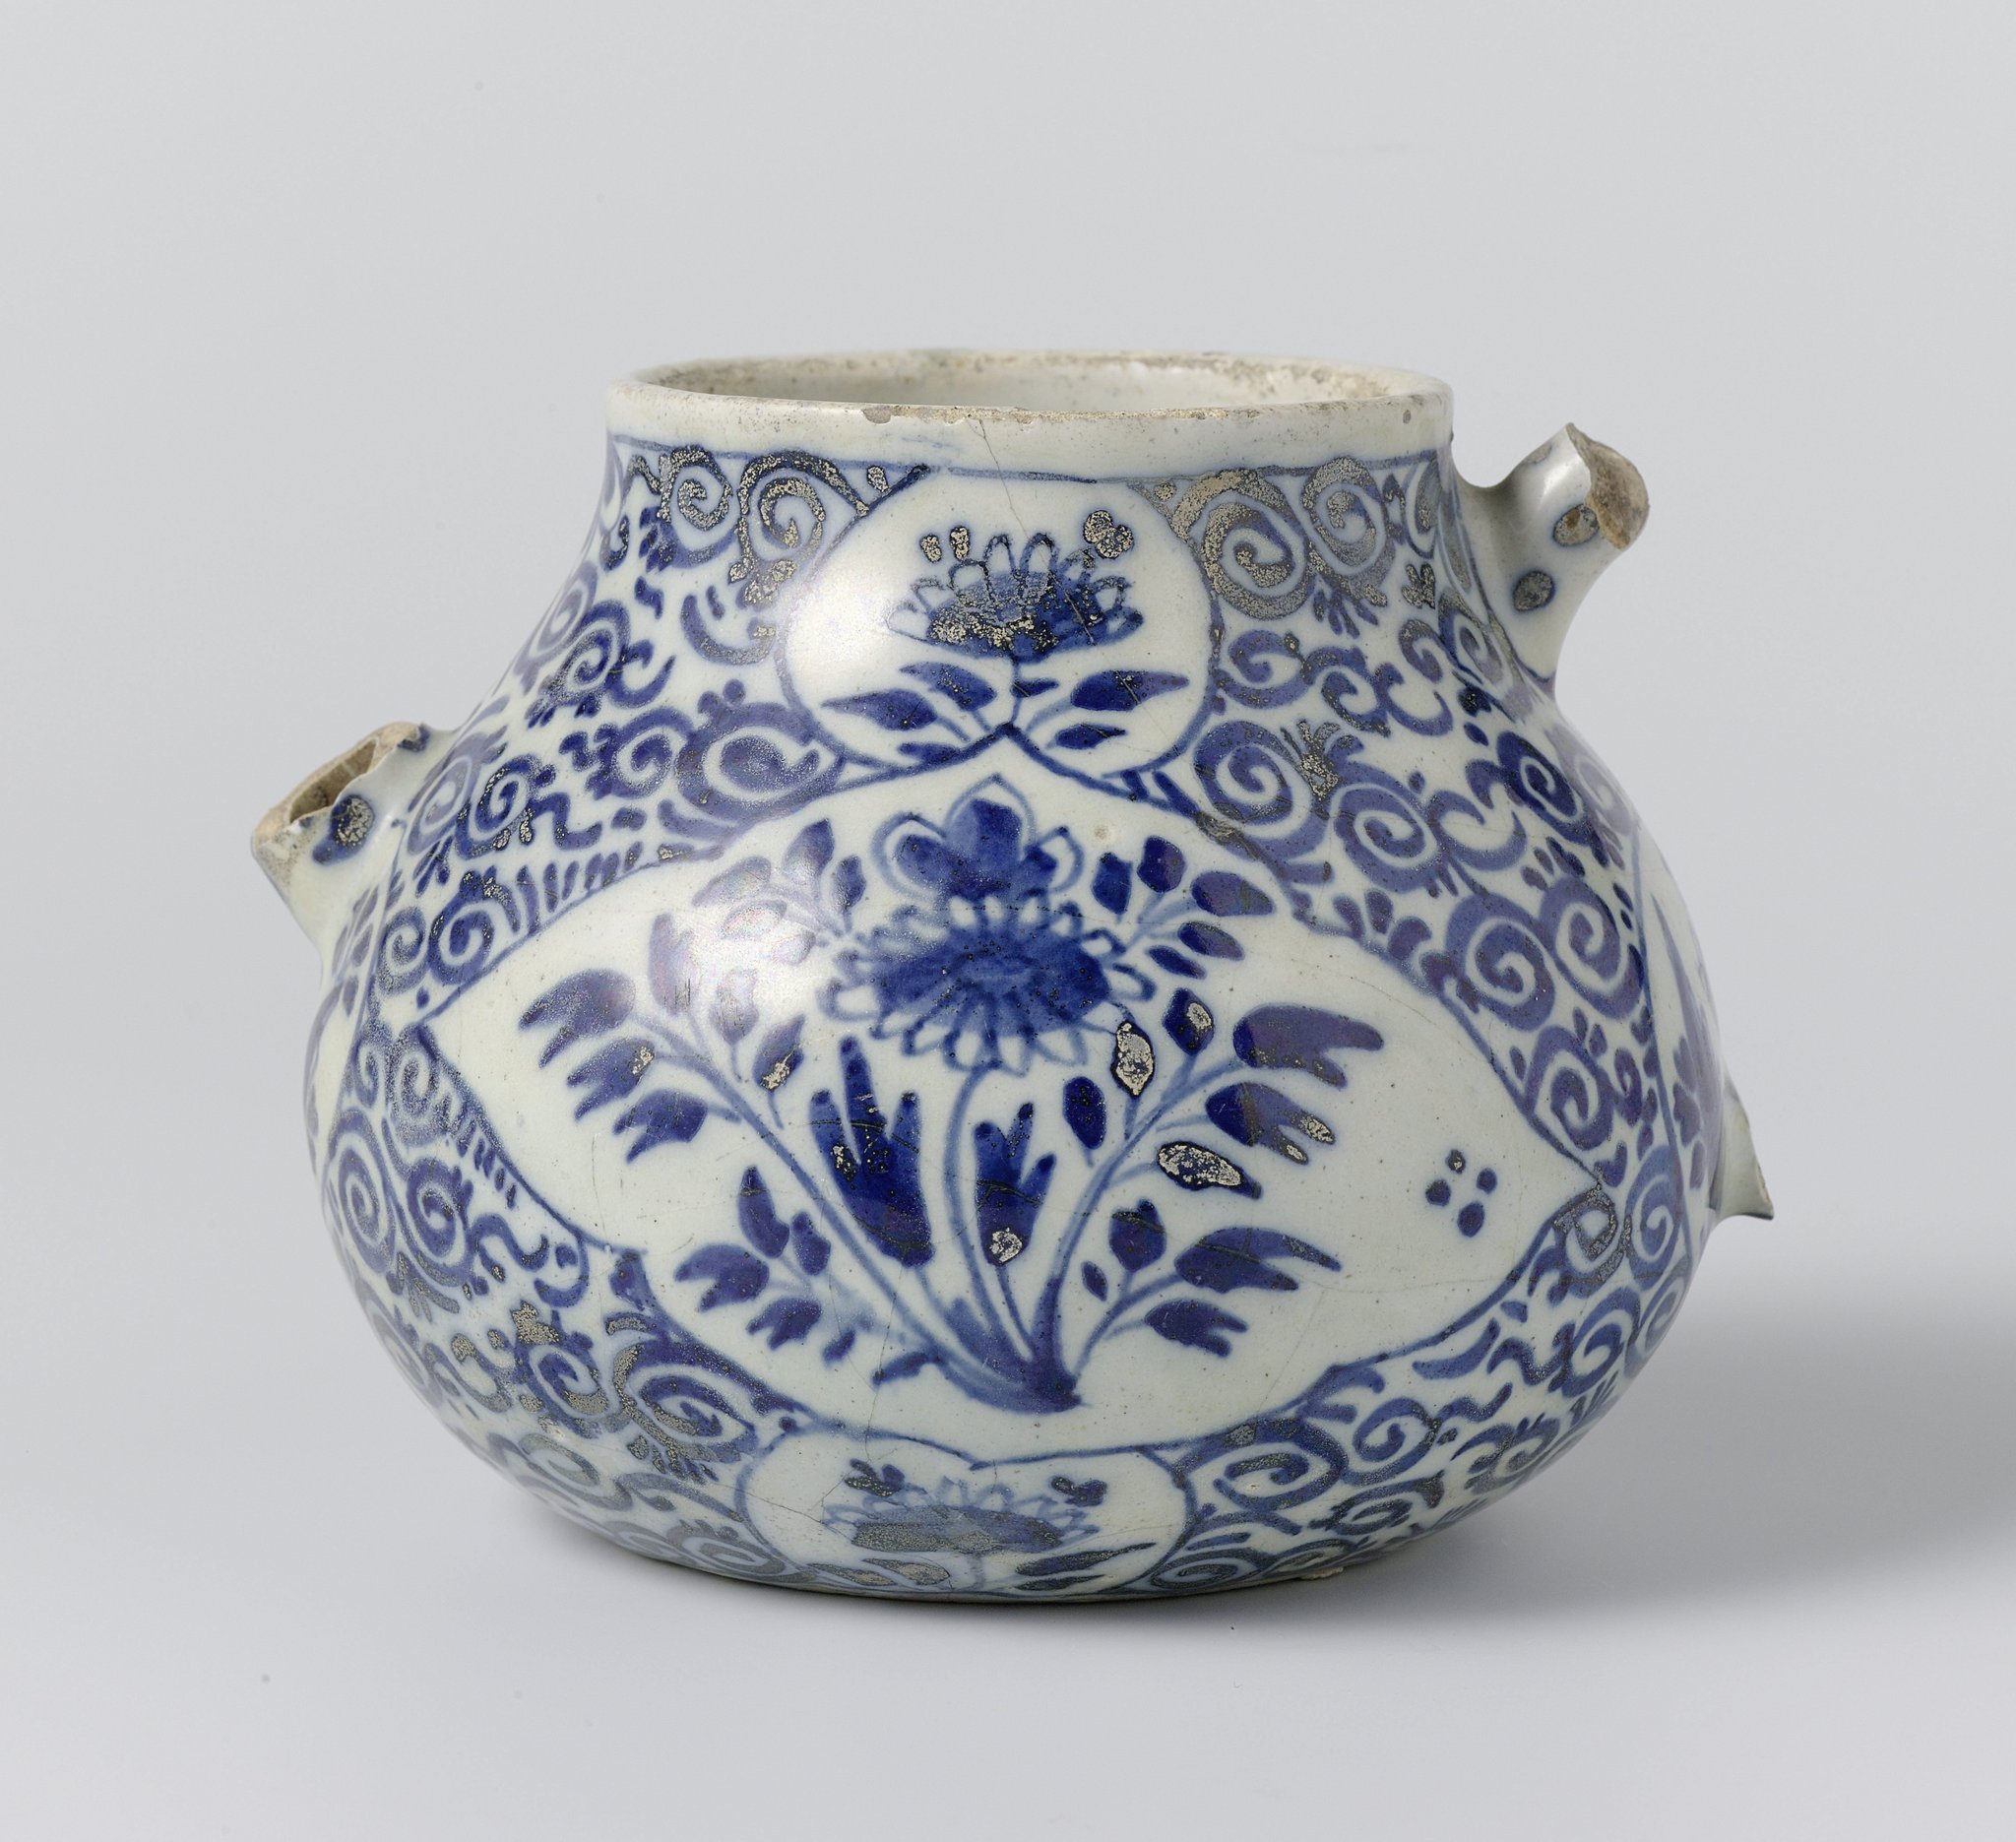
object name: teapot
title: Theepot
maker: Anonymous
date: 1700-1750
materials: faience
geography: delft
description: Theepot van faience. Blauw beschilderd met ranken en bloemen. Oor en tuit zijn afgebroken.